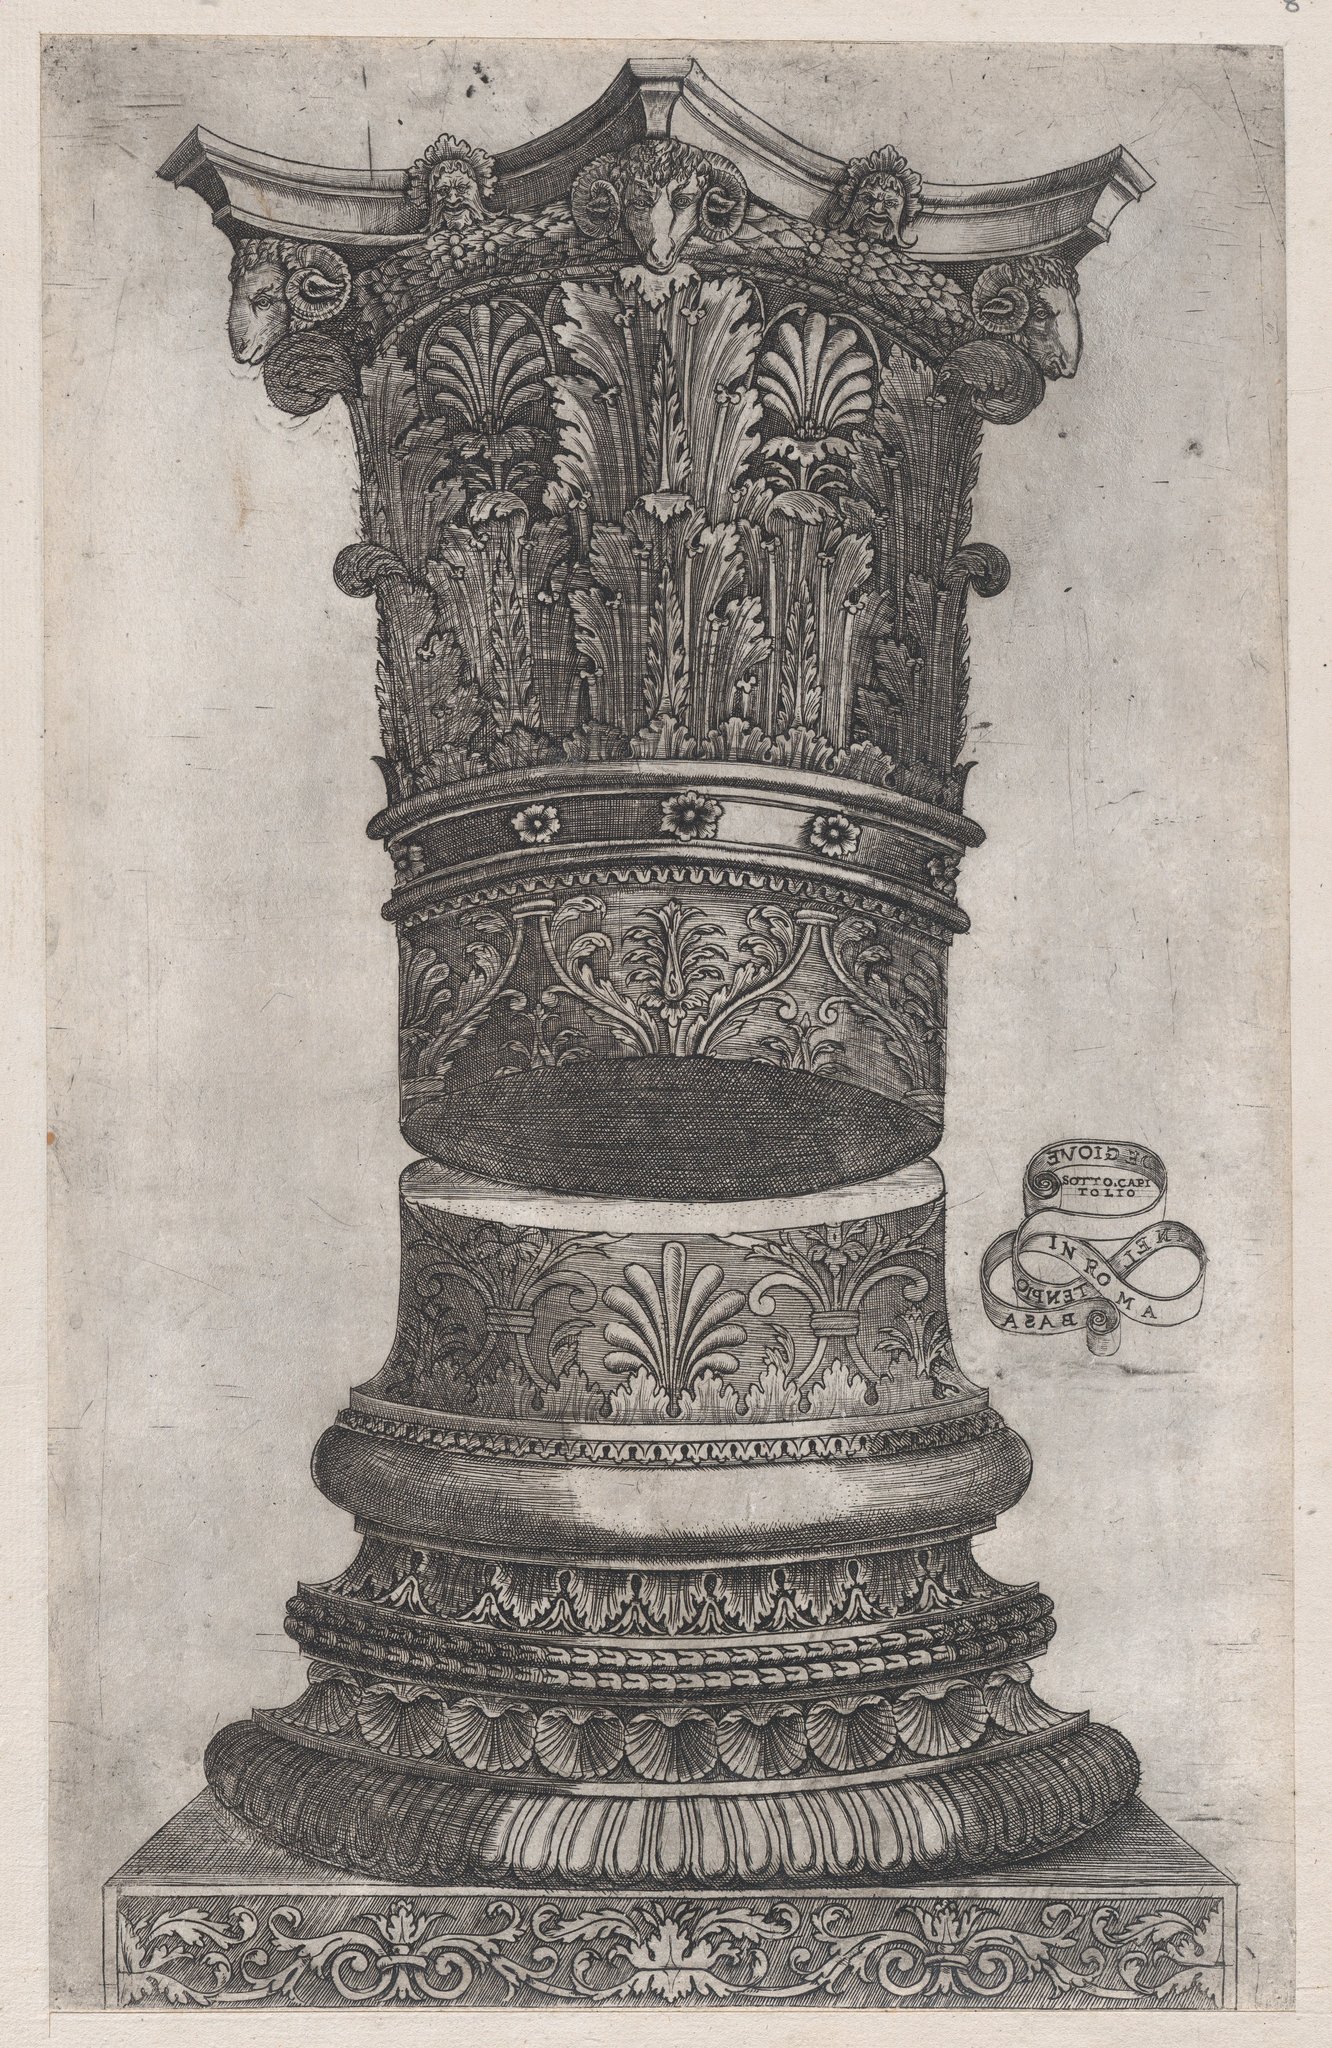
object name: print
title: Decorated capital and base in the Temple of Jupiter, Rome, from "Speculum Romanae Magnificentiae"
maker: monogrammist g.a. with the caltrop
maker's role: artist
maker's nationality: italian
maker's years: 1535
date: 1537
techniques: engraving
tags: capitals